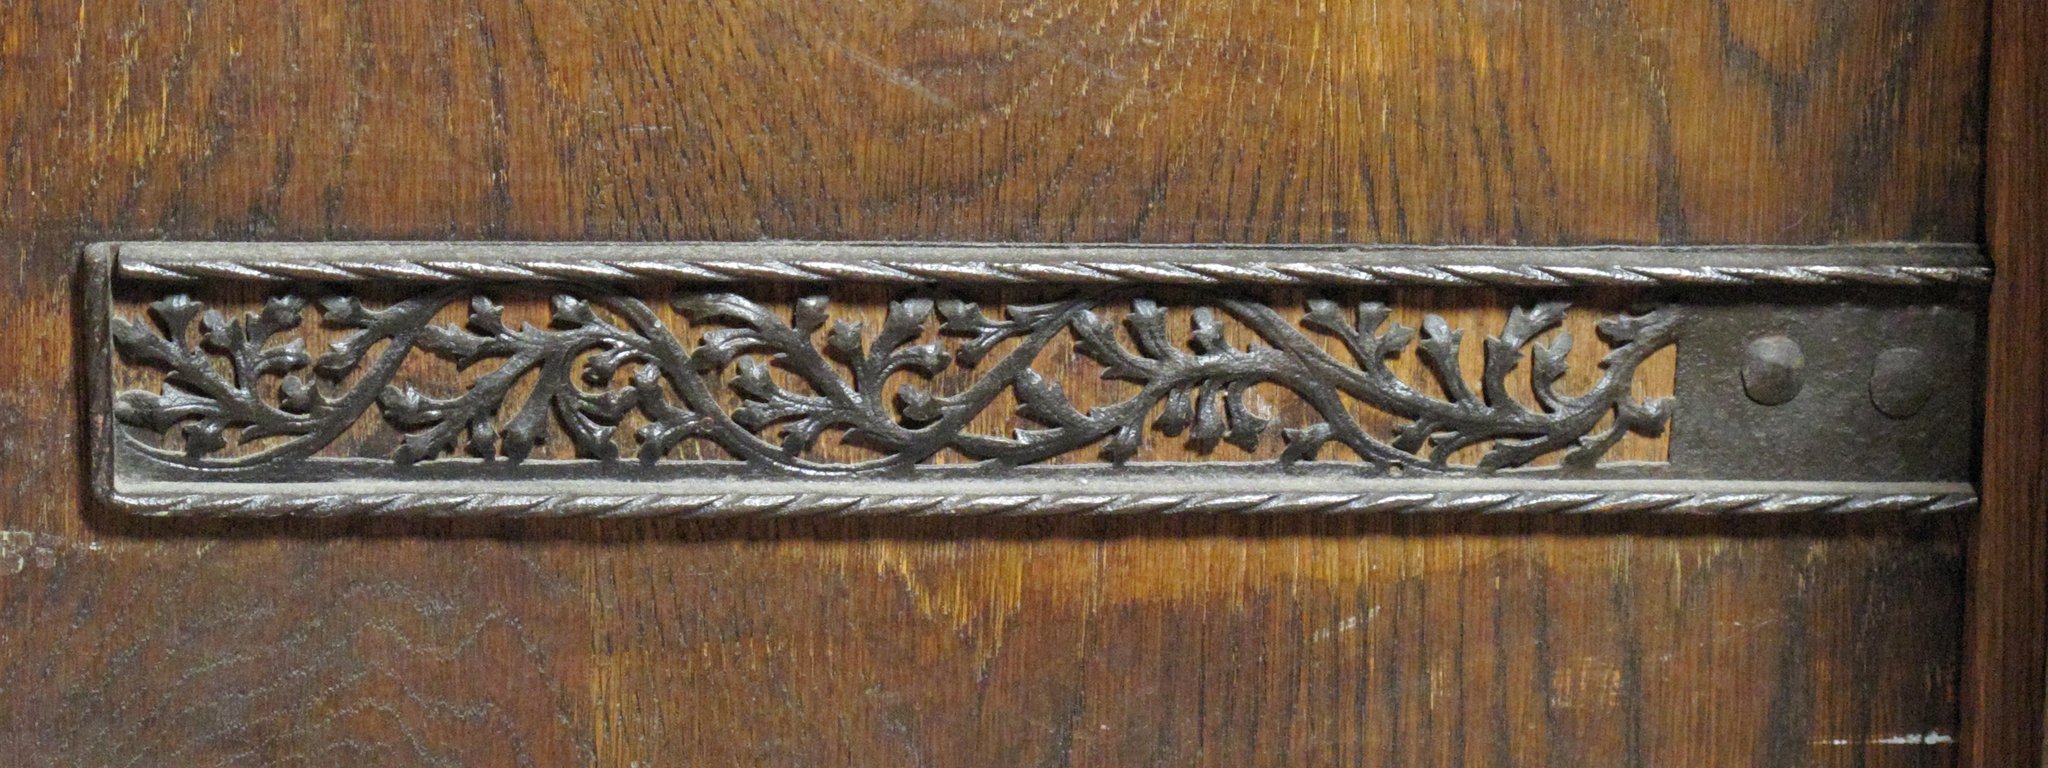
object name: hinge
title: Strap Hinge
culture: european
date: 1401-1600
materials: iron